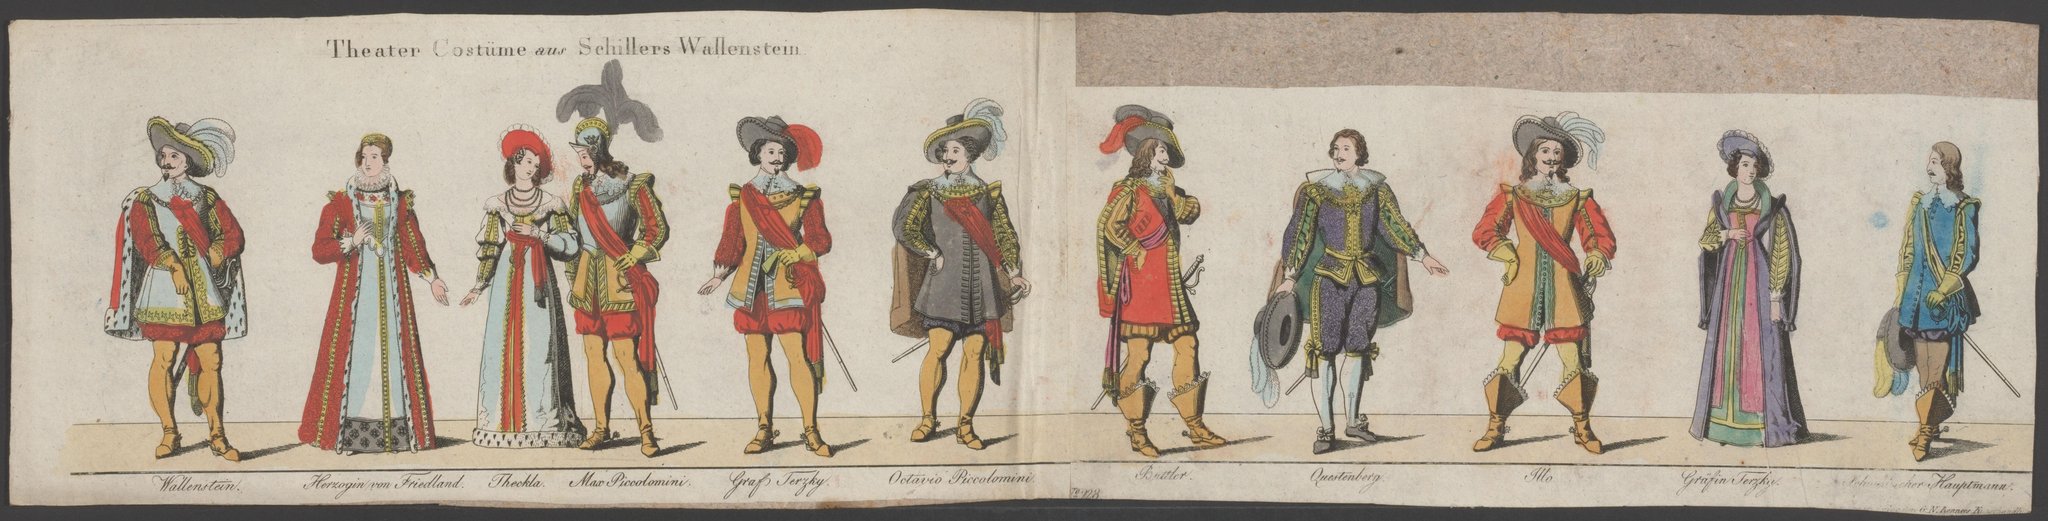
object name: print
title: Theater Costüme aus Schillers Wallerstein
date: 1815-1858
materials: paper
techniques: etching, hand coloring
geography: dusseldorf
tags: stage costume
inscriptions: stamp, collector's mark: Lugt 1641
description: Linksonder genummerd: No. 228. Onderwerpsrubrieken binnen de Atlas Zeden en Gewoonten: Zeden en gewoonten in engeren zin, Des menschen begin, midden en einde, Kinderprenten opgeplakt op karton.